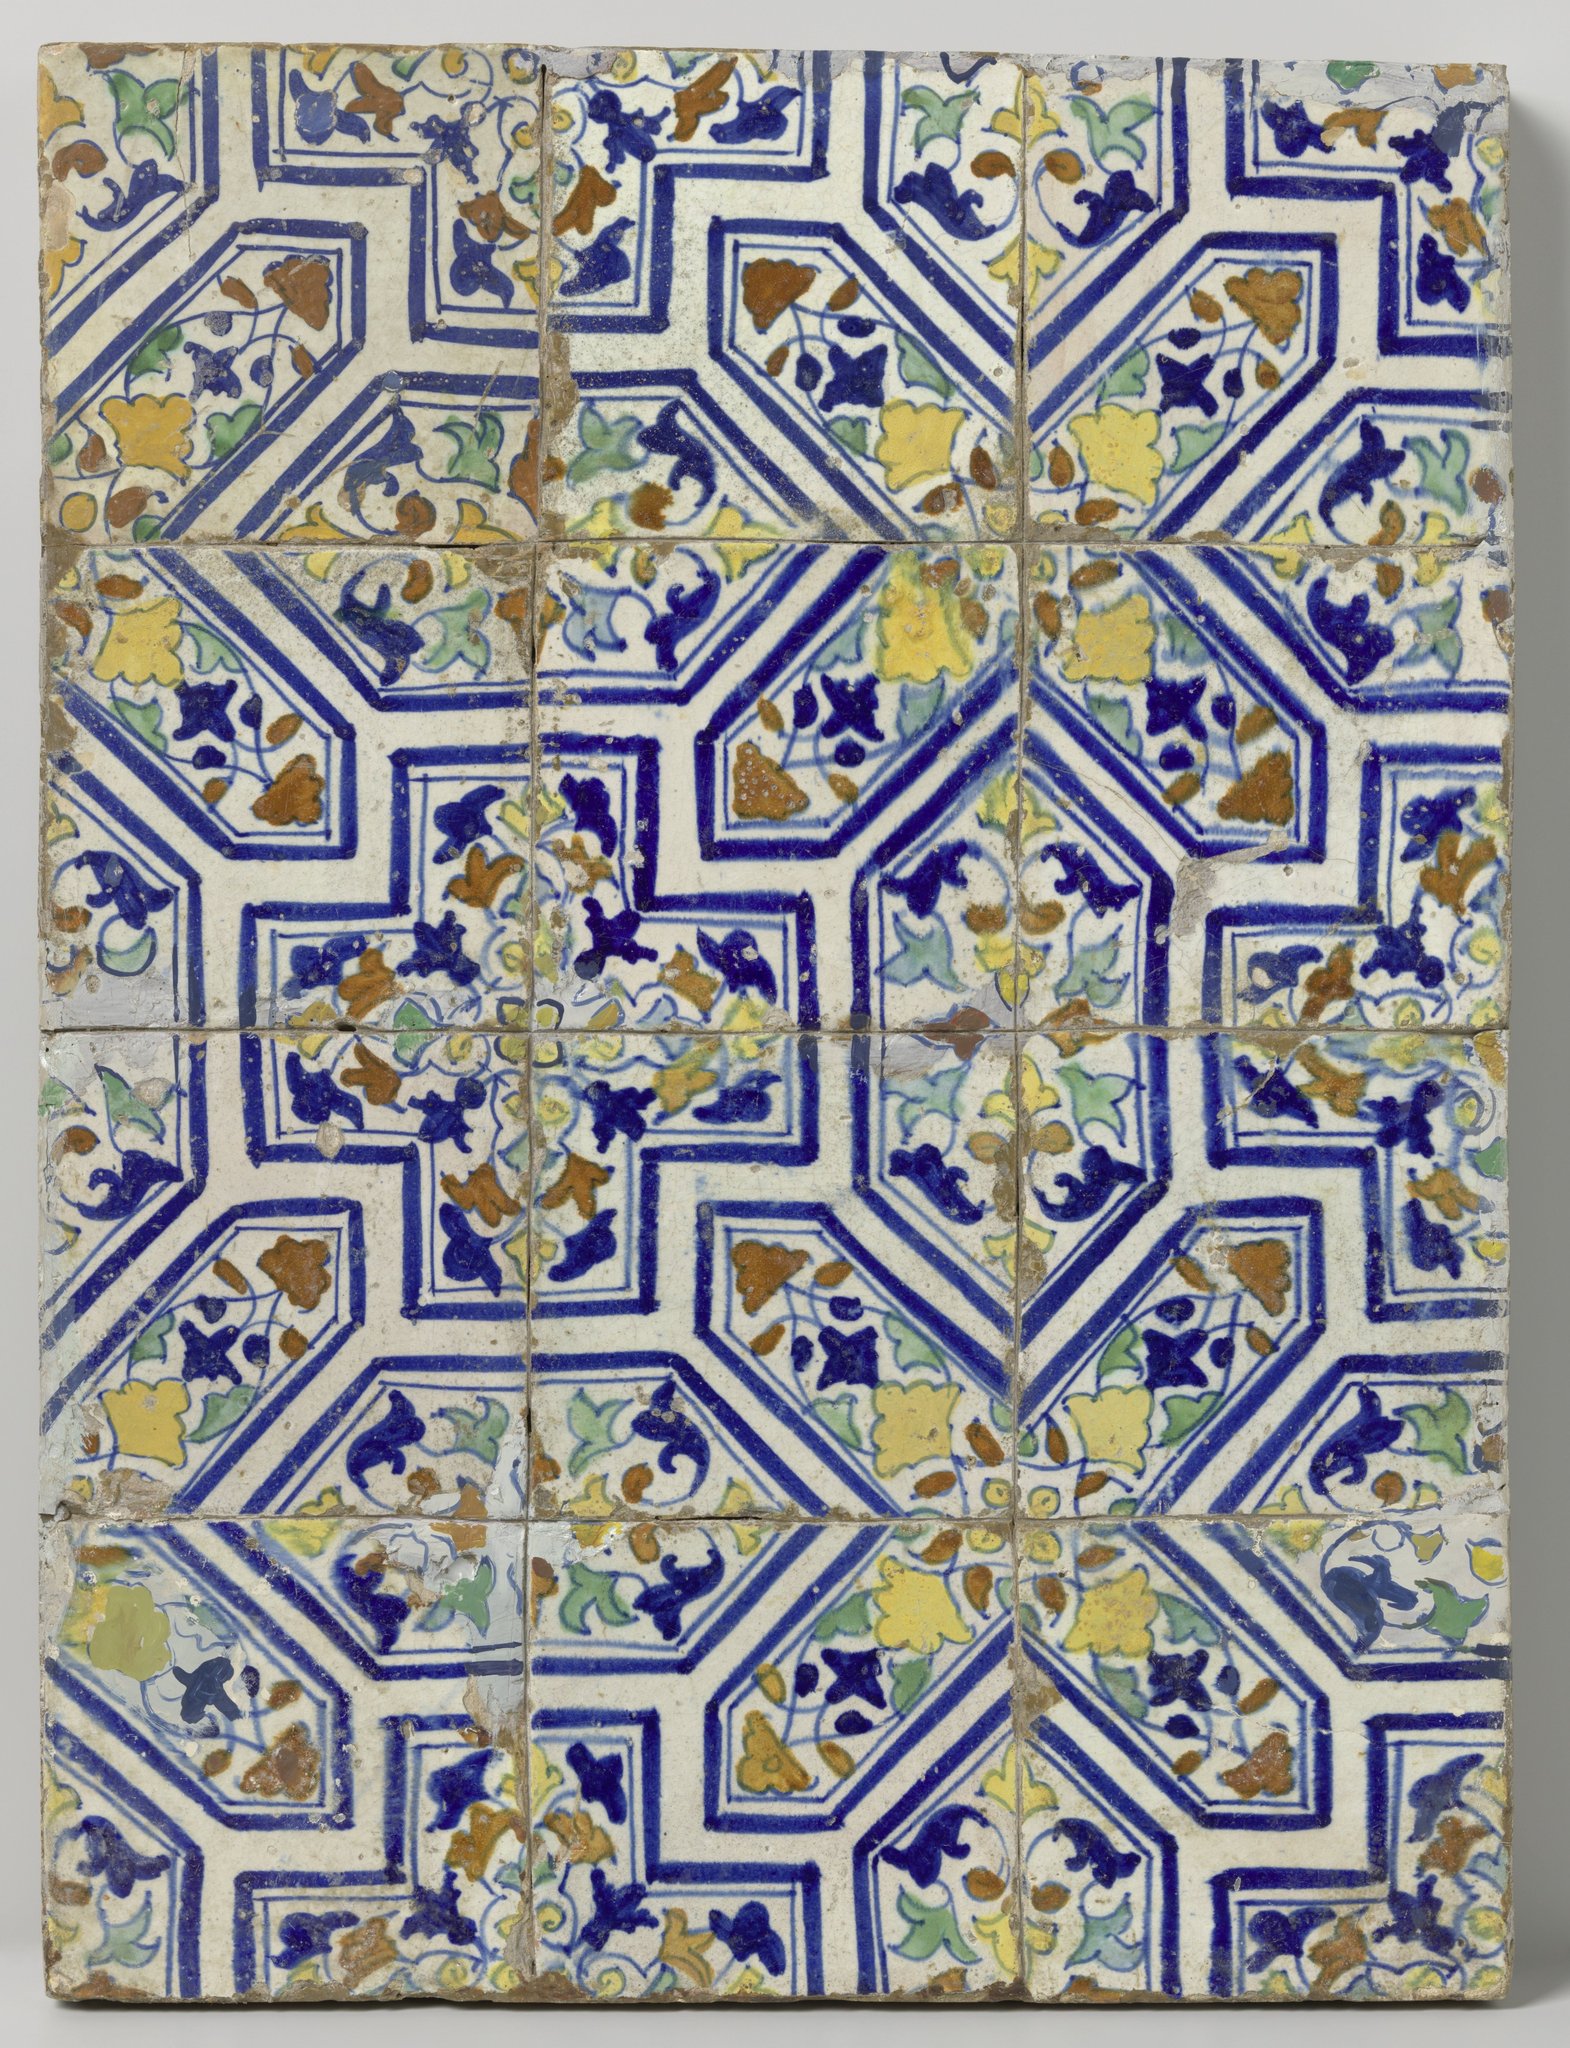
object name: tile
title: Veld van twaalf tegels met bladpatroon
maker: Anonymous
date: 1610-1625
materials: earthenware, glaze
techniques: maiolica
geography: netherlands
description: Veld van twaalf tegels (4 x 3) met veelkleurig (blauw, geel, groen en oranjebruin) geschilderde bladpatronen binnen kruisen en achtkanten.